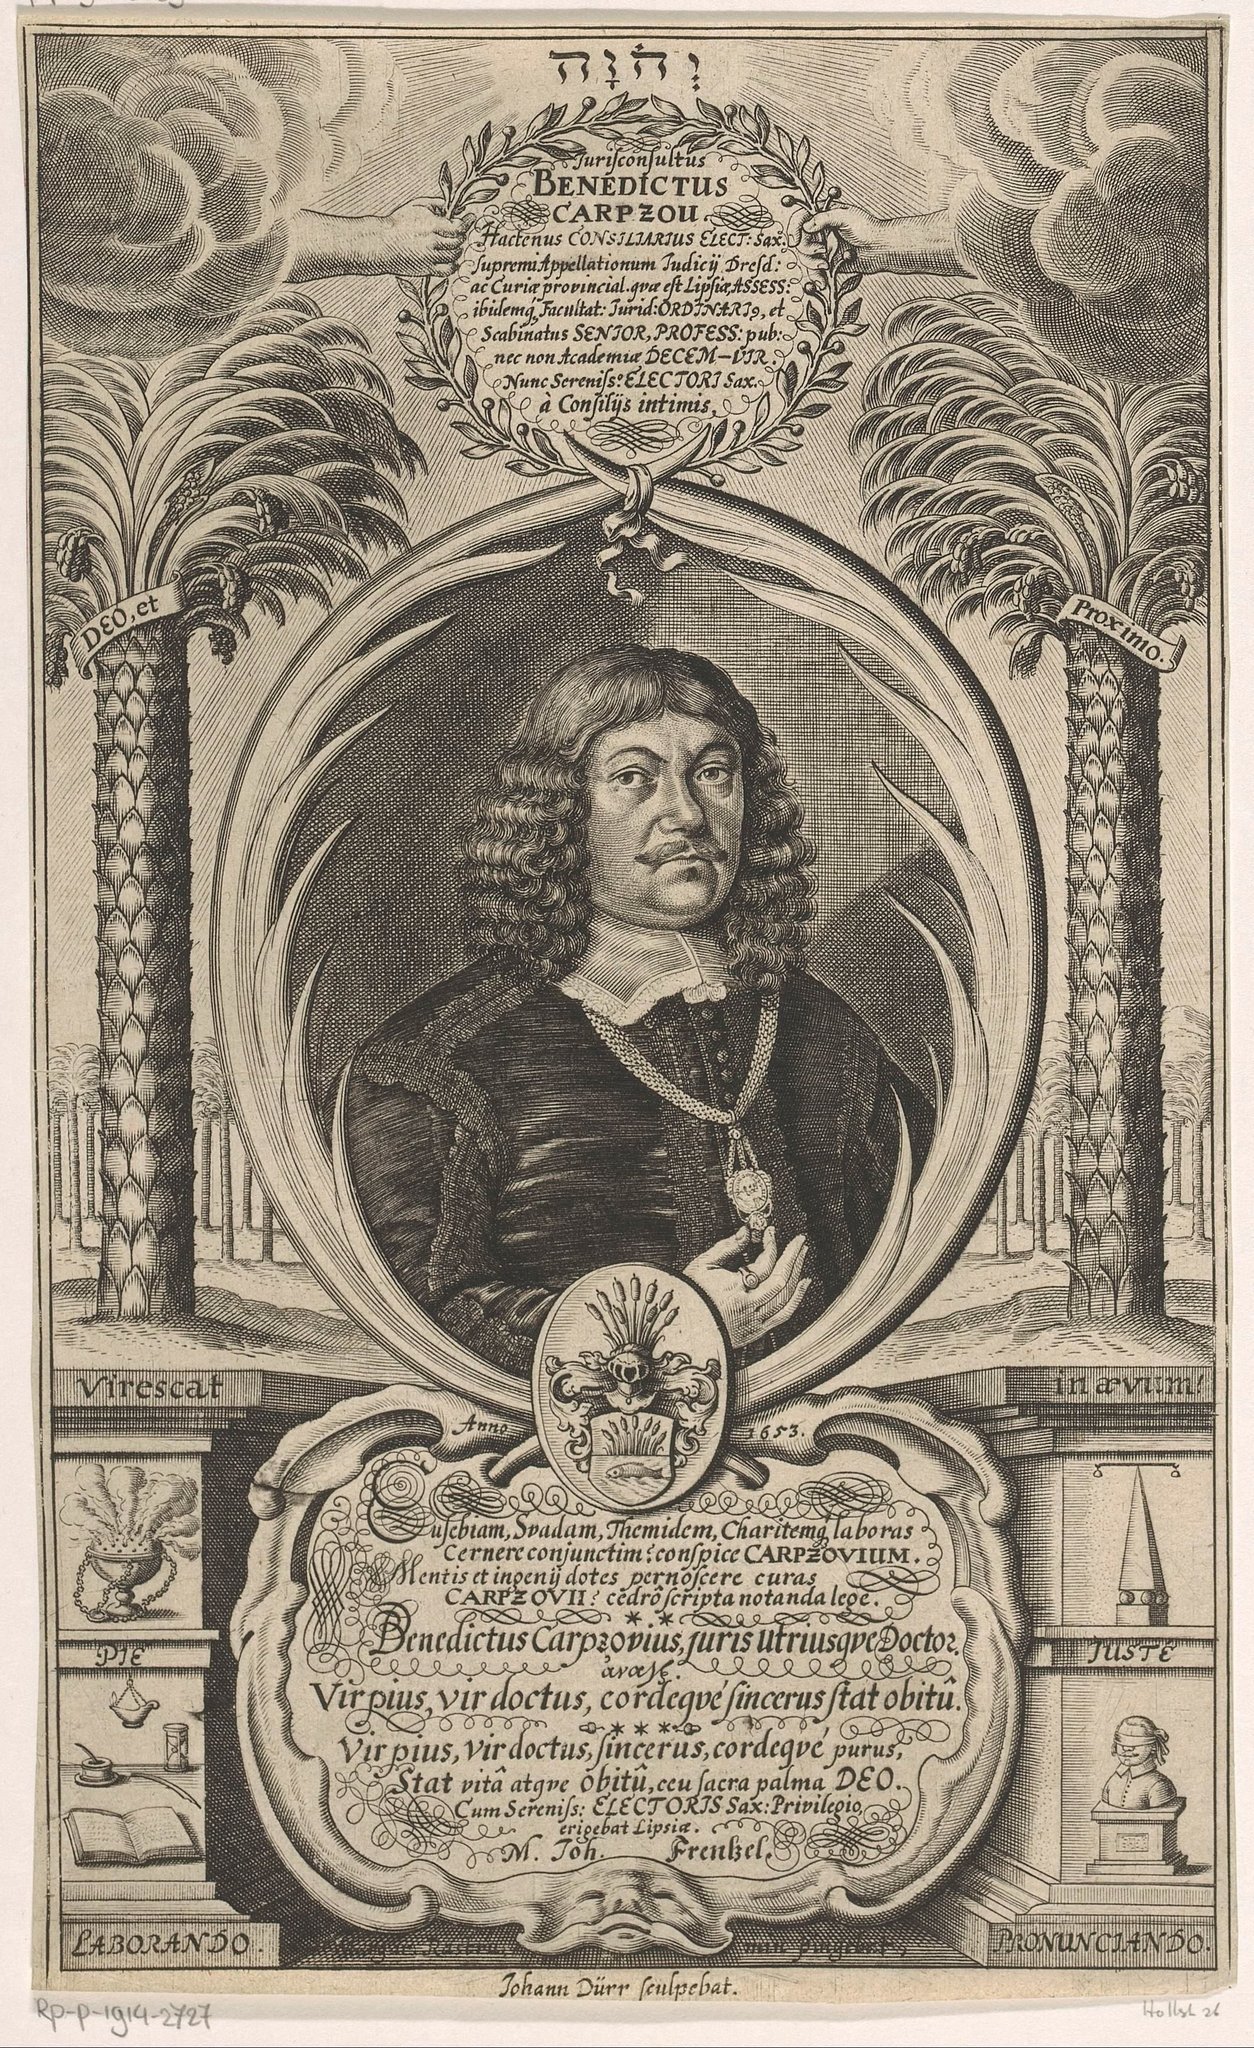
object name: print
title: Portret van Benedict Carpzov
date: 1653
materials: paper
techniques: engraving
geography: germany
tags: historical persons, pendant, trinket, 'breloque', calligraphy, trees: palm-tree, crowning with laurel, armorial bearing, heraldry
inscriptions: collector's mark: Lugt 2228